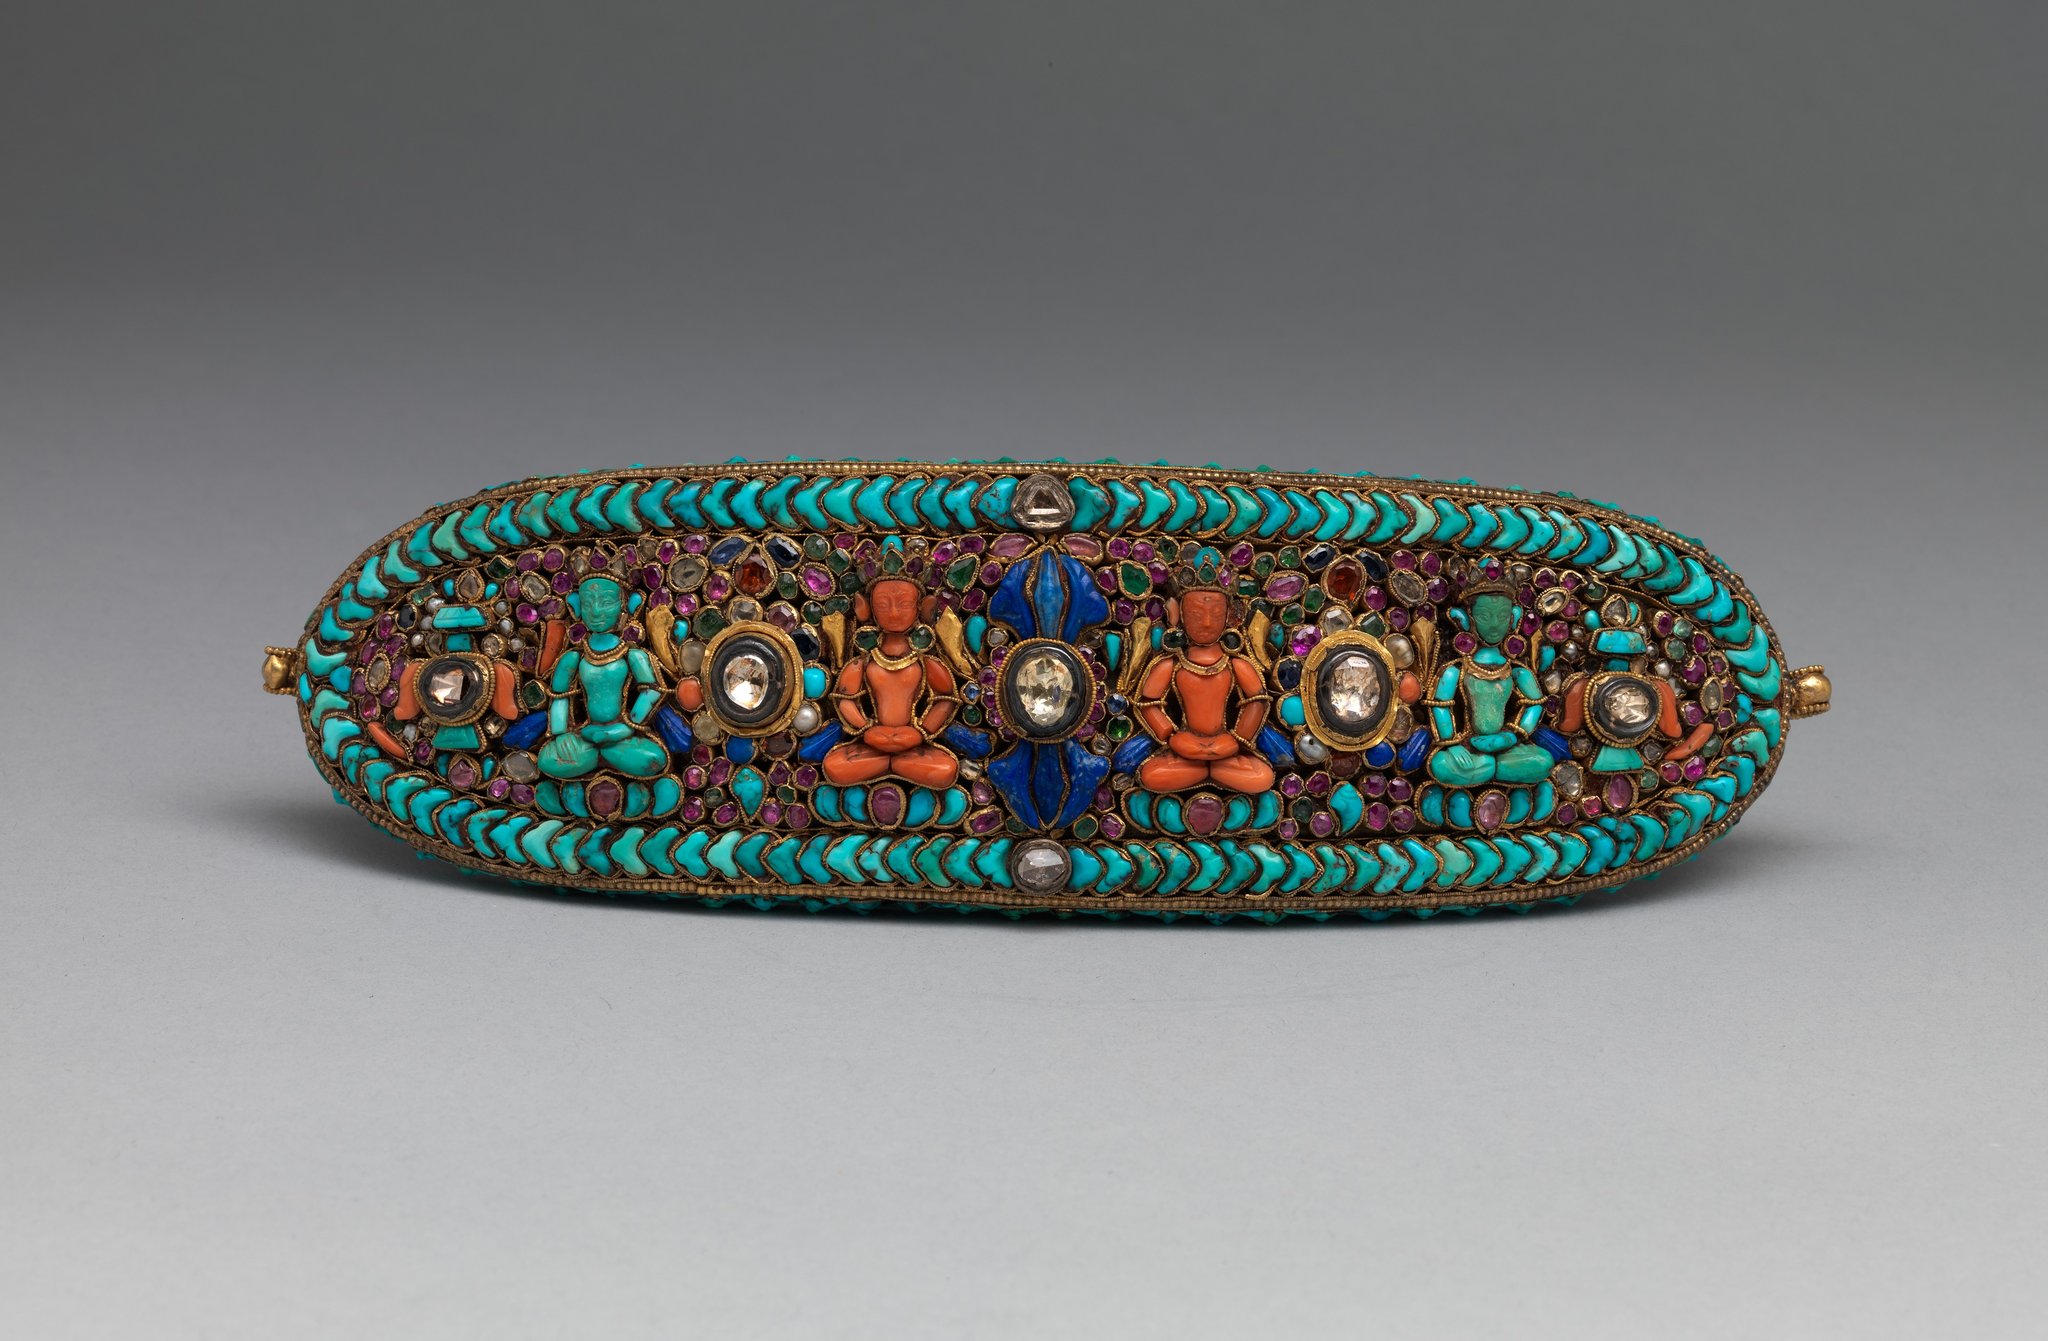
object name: ornament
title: Forehead Ornament for a Deity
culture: newari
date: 1601-1900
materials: amber, coral, diamond, gemstone, gold, lapis lazuli, mother of pearl, pearl, shell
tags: buddha